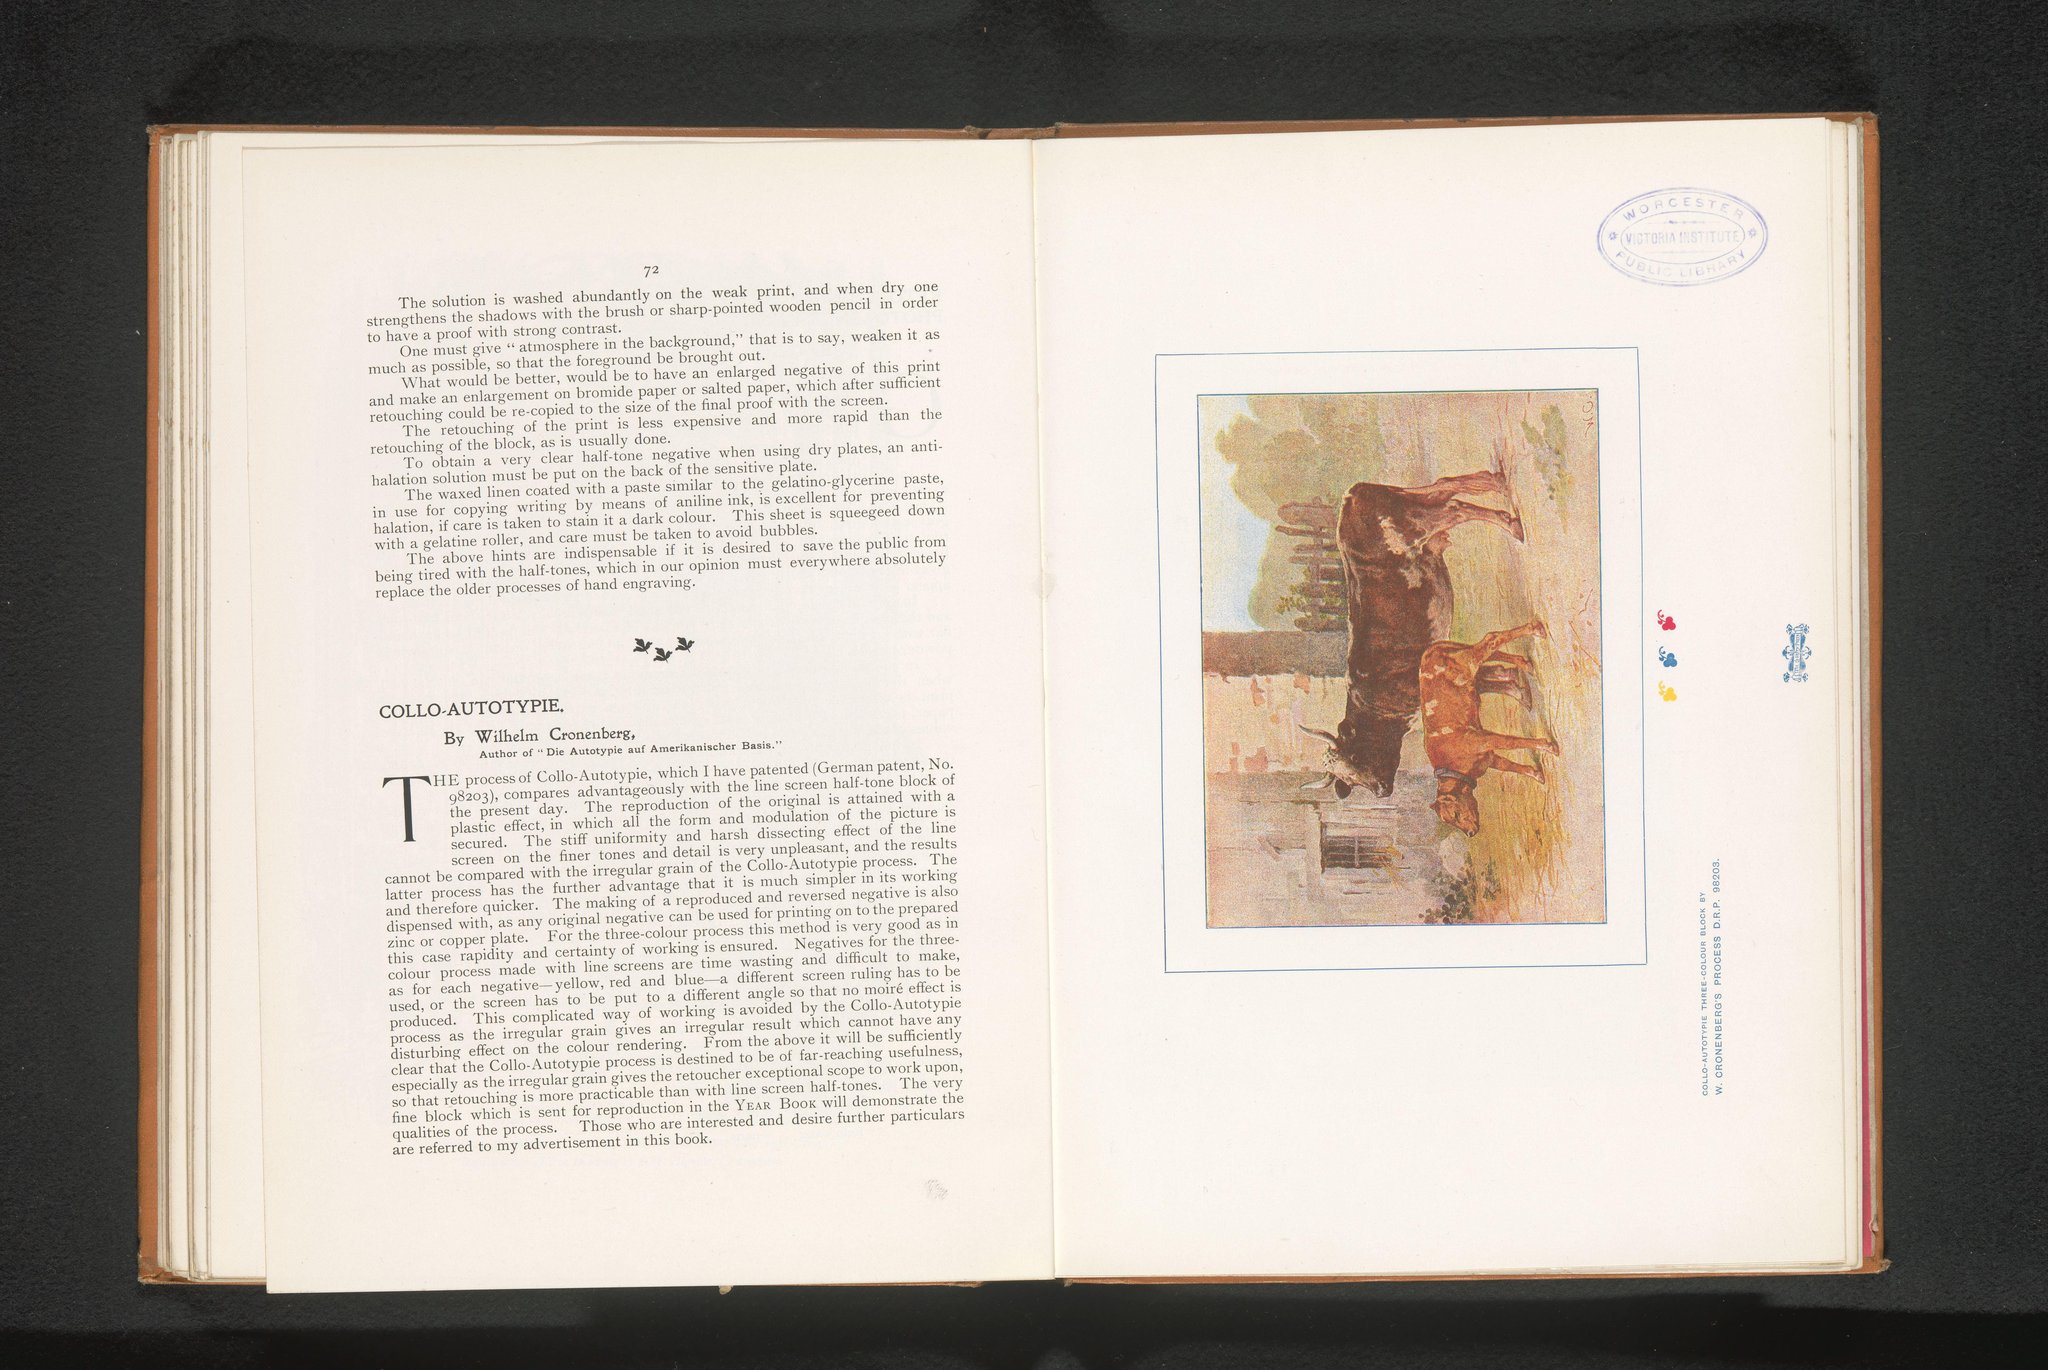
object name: reproduction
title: Reproductie van een tekening van een koe met kalf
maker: wilhelm cronenberg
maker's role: fotograaf, schrijver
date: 1894-1899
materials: paper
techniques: collo-autotype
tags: cow, calf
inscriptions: collector's mark: ‘Worcester Public Library/ Victoria Institute’